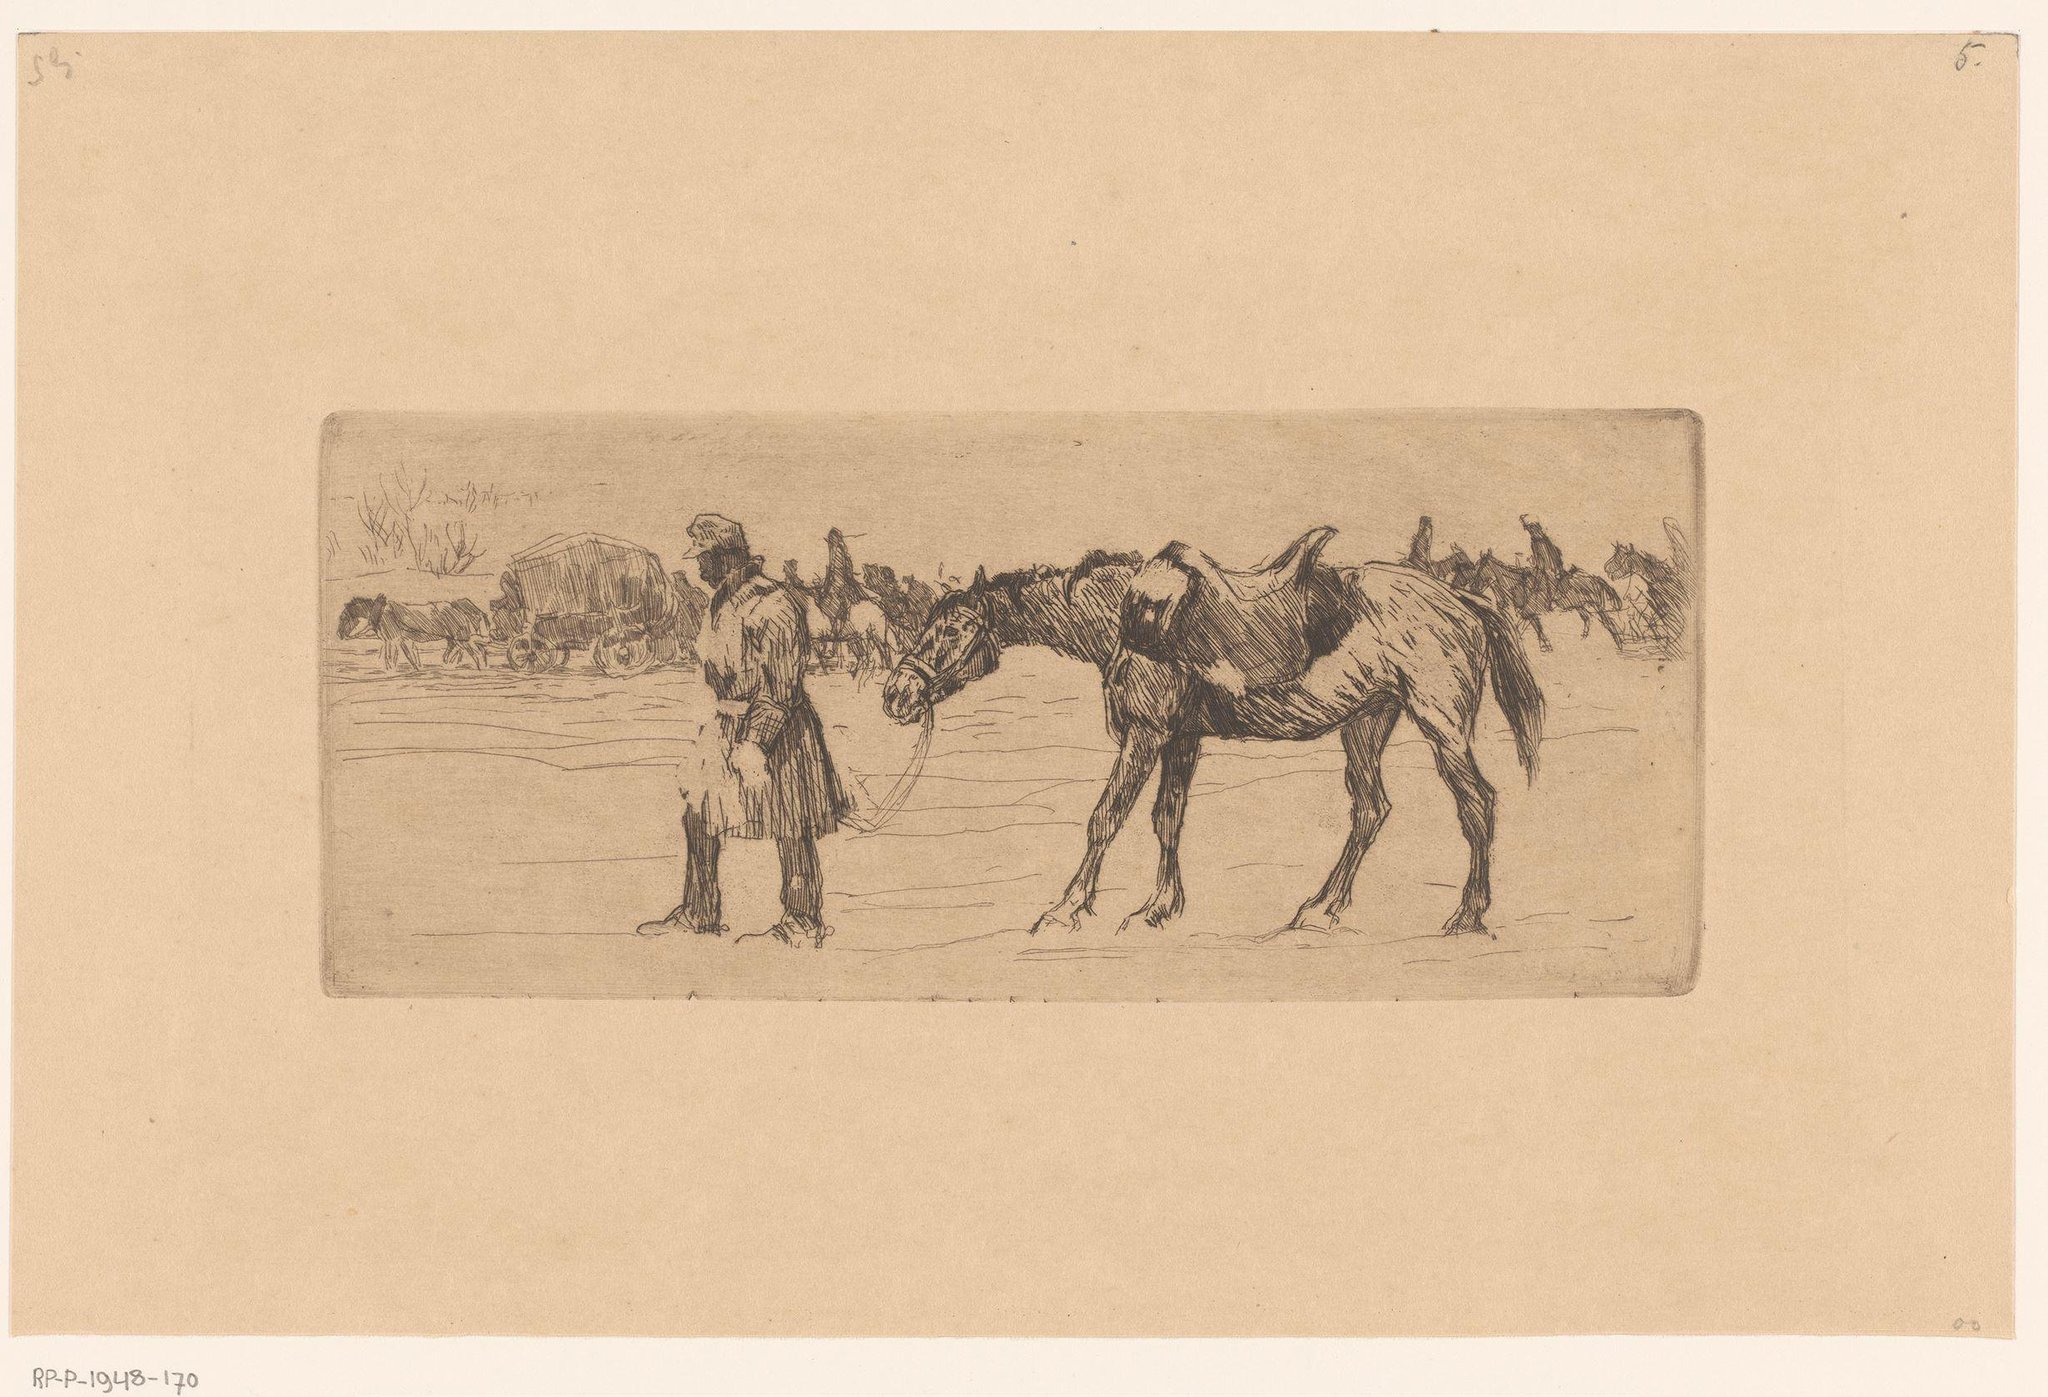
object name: print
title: Sneeuwlandschap met stoet van soldaten en paarden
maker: marcel roux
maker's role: print maker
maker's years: 1878-1922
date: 1900-1922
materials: paper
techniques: etching, intaglio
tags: the soldier; the soldier's life, horse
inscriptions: collector's mark: Lugt 2228